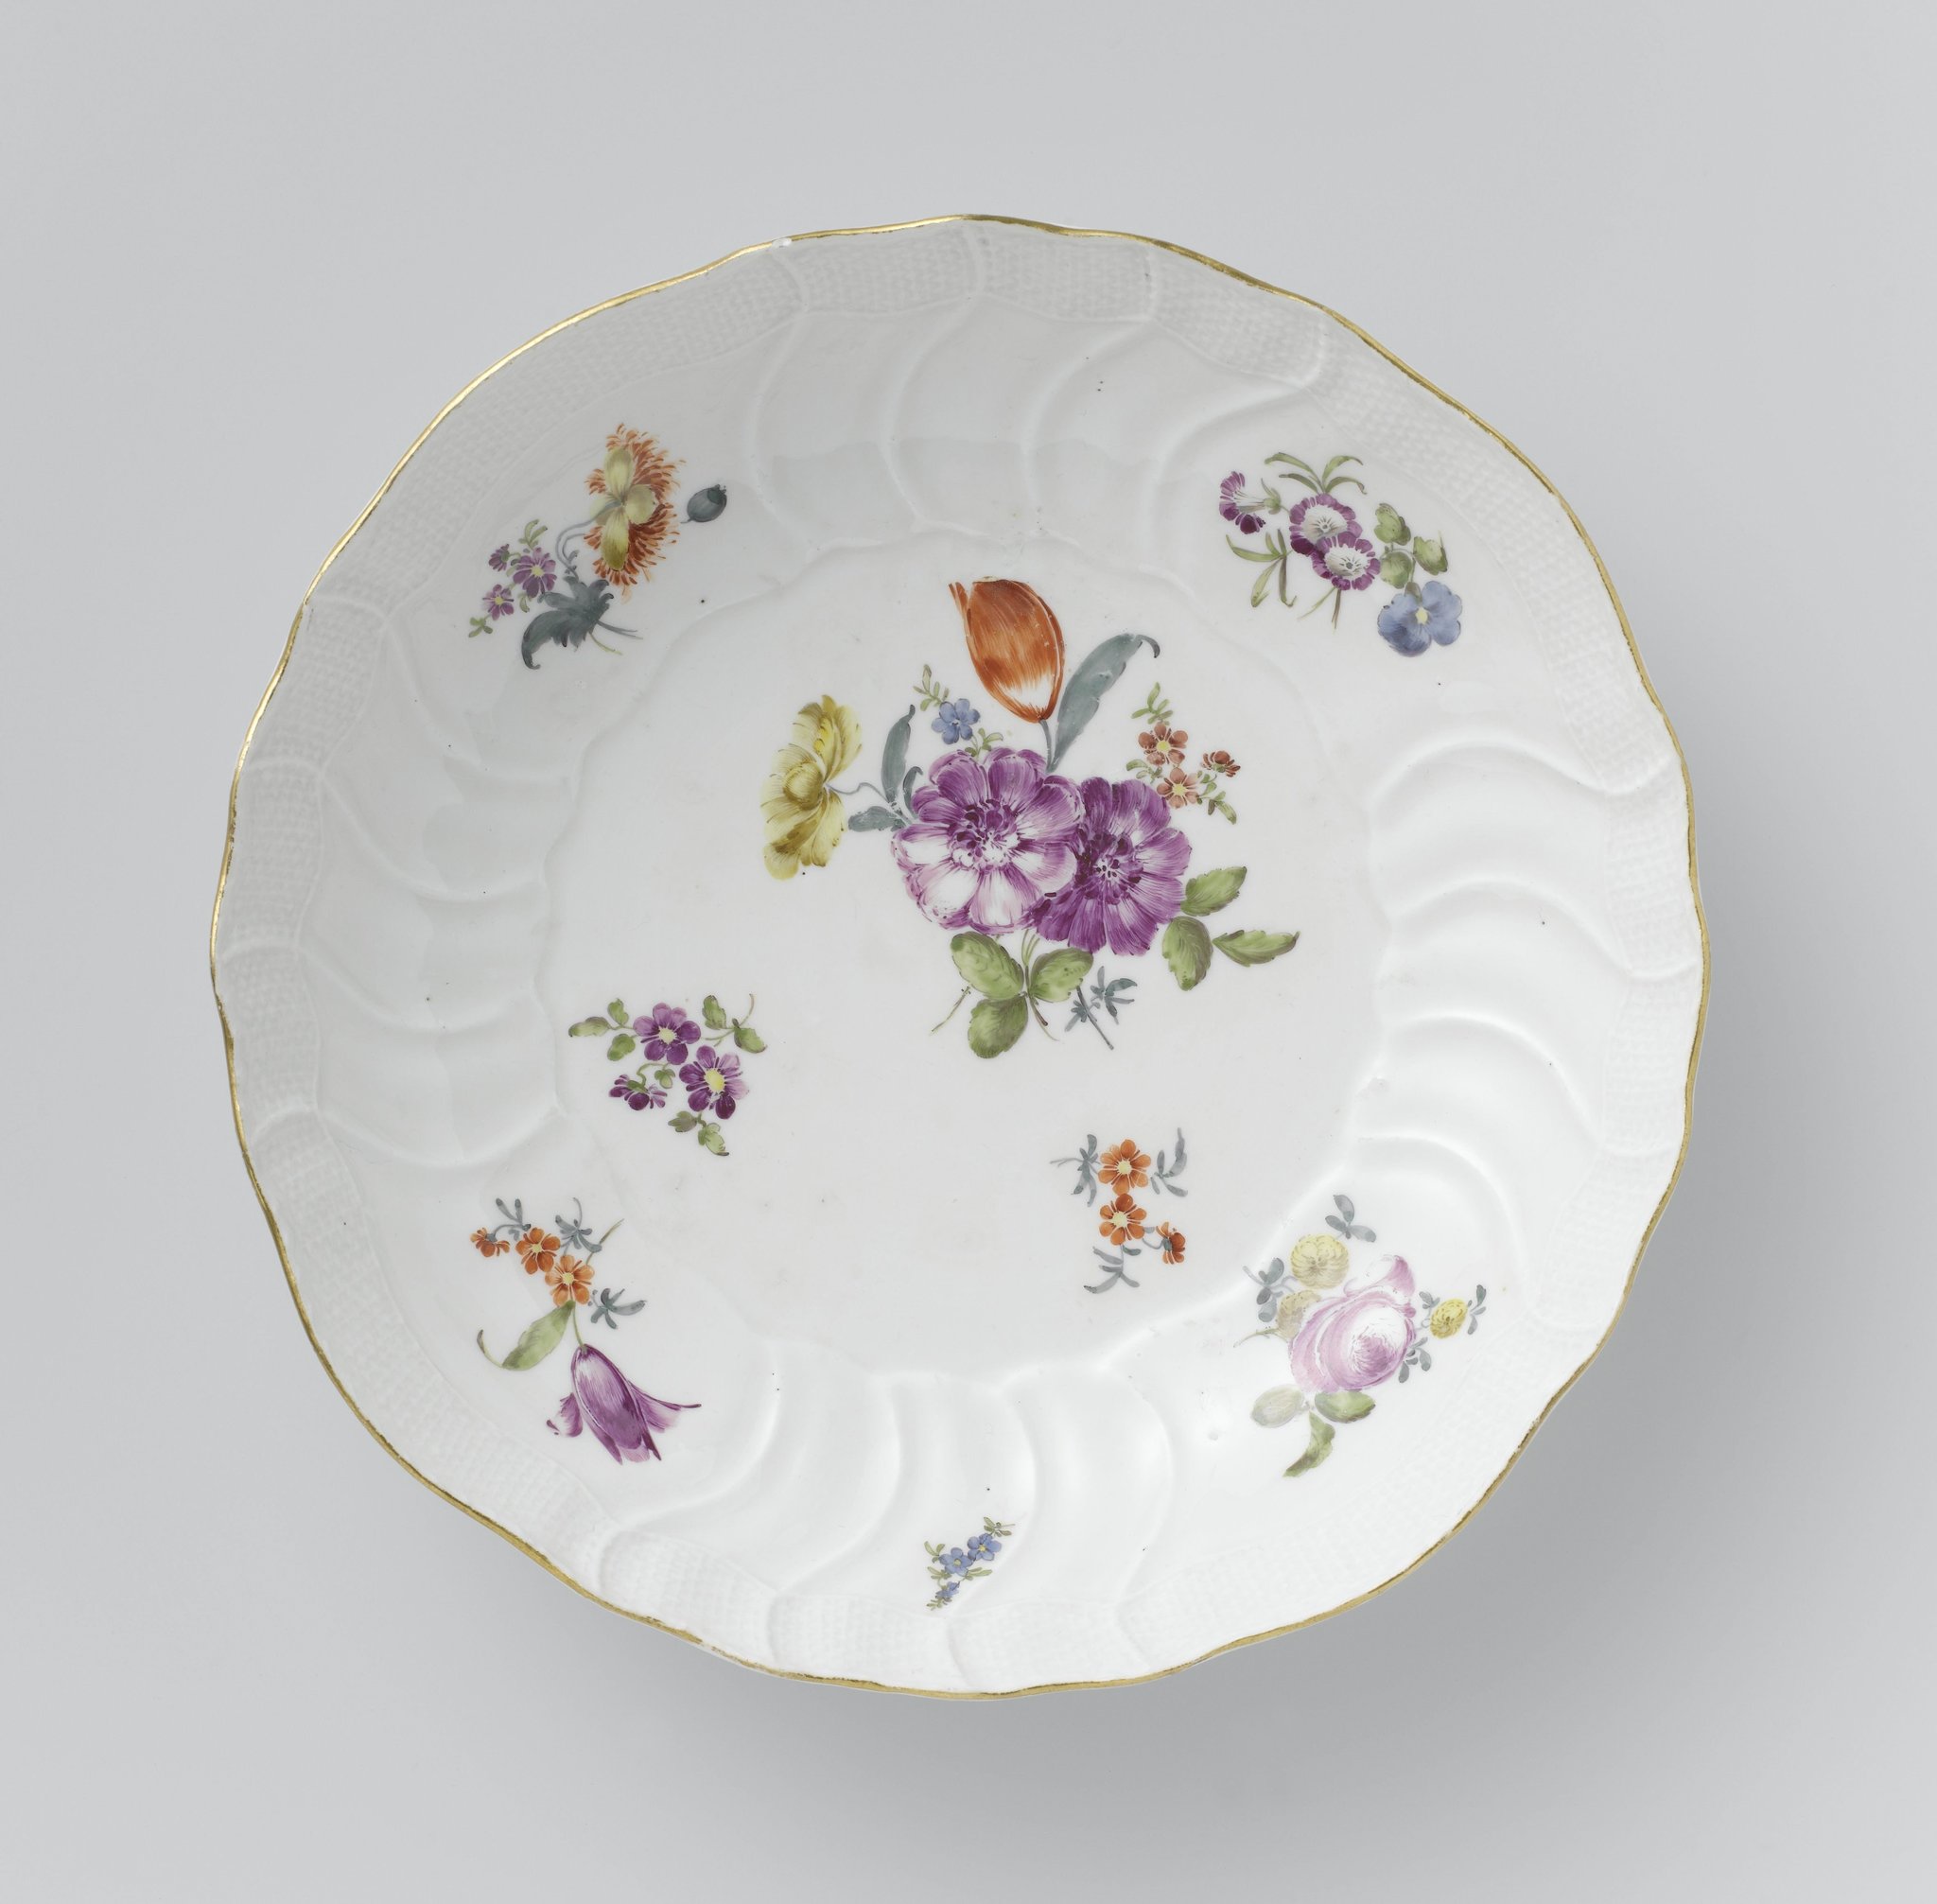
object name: eating drinking utensil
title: Schotel, veelkleurig beschilderd met Deutsche Blumen, insekten en vruchten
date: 1750-1760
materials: porcelain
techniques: painted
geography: meissen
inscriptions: factory mark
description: Ronde schotel van beschilderd porselein. De schotel is beschilderd met Deutsche Blumen, insekten en vruchten. De rand is in reliëf versierd met het Neuozier-patroon. De schotel is gemerkt en hoort bij een servies (BK-17474-1 t/m BK-17474-253).